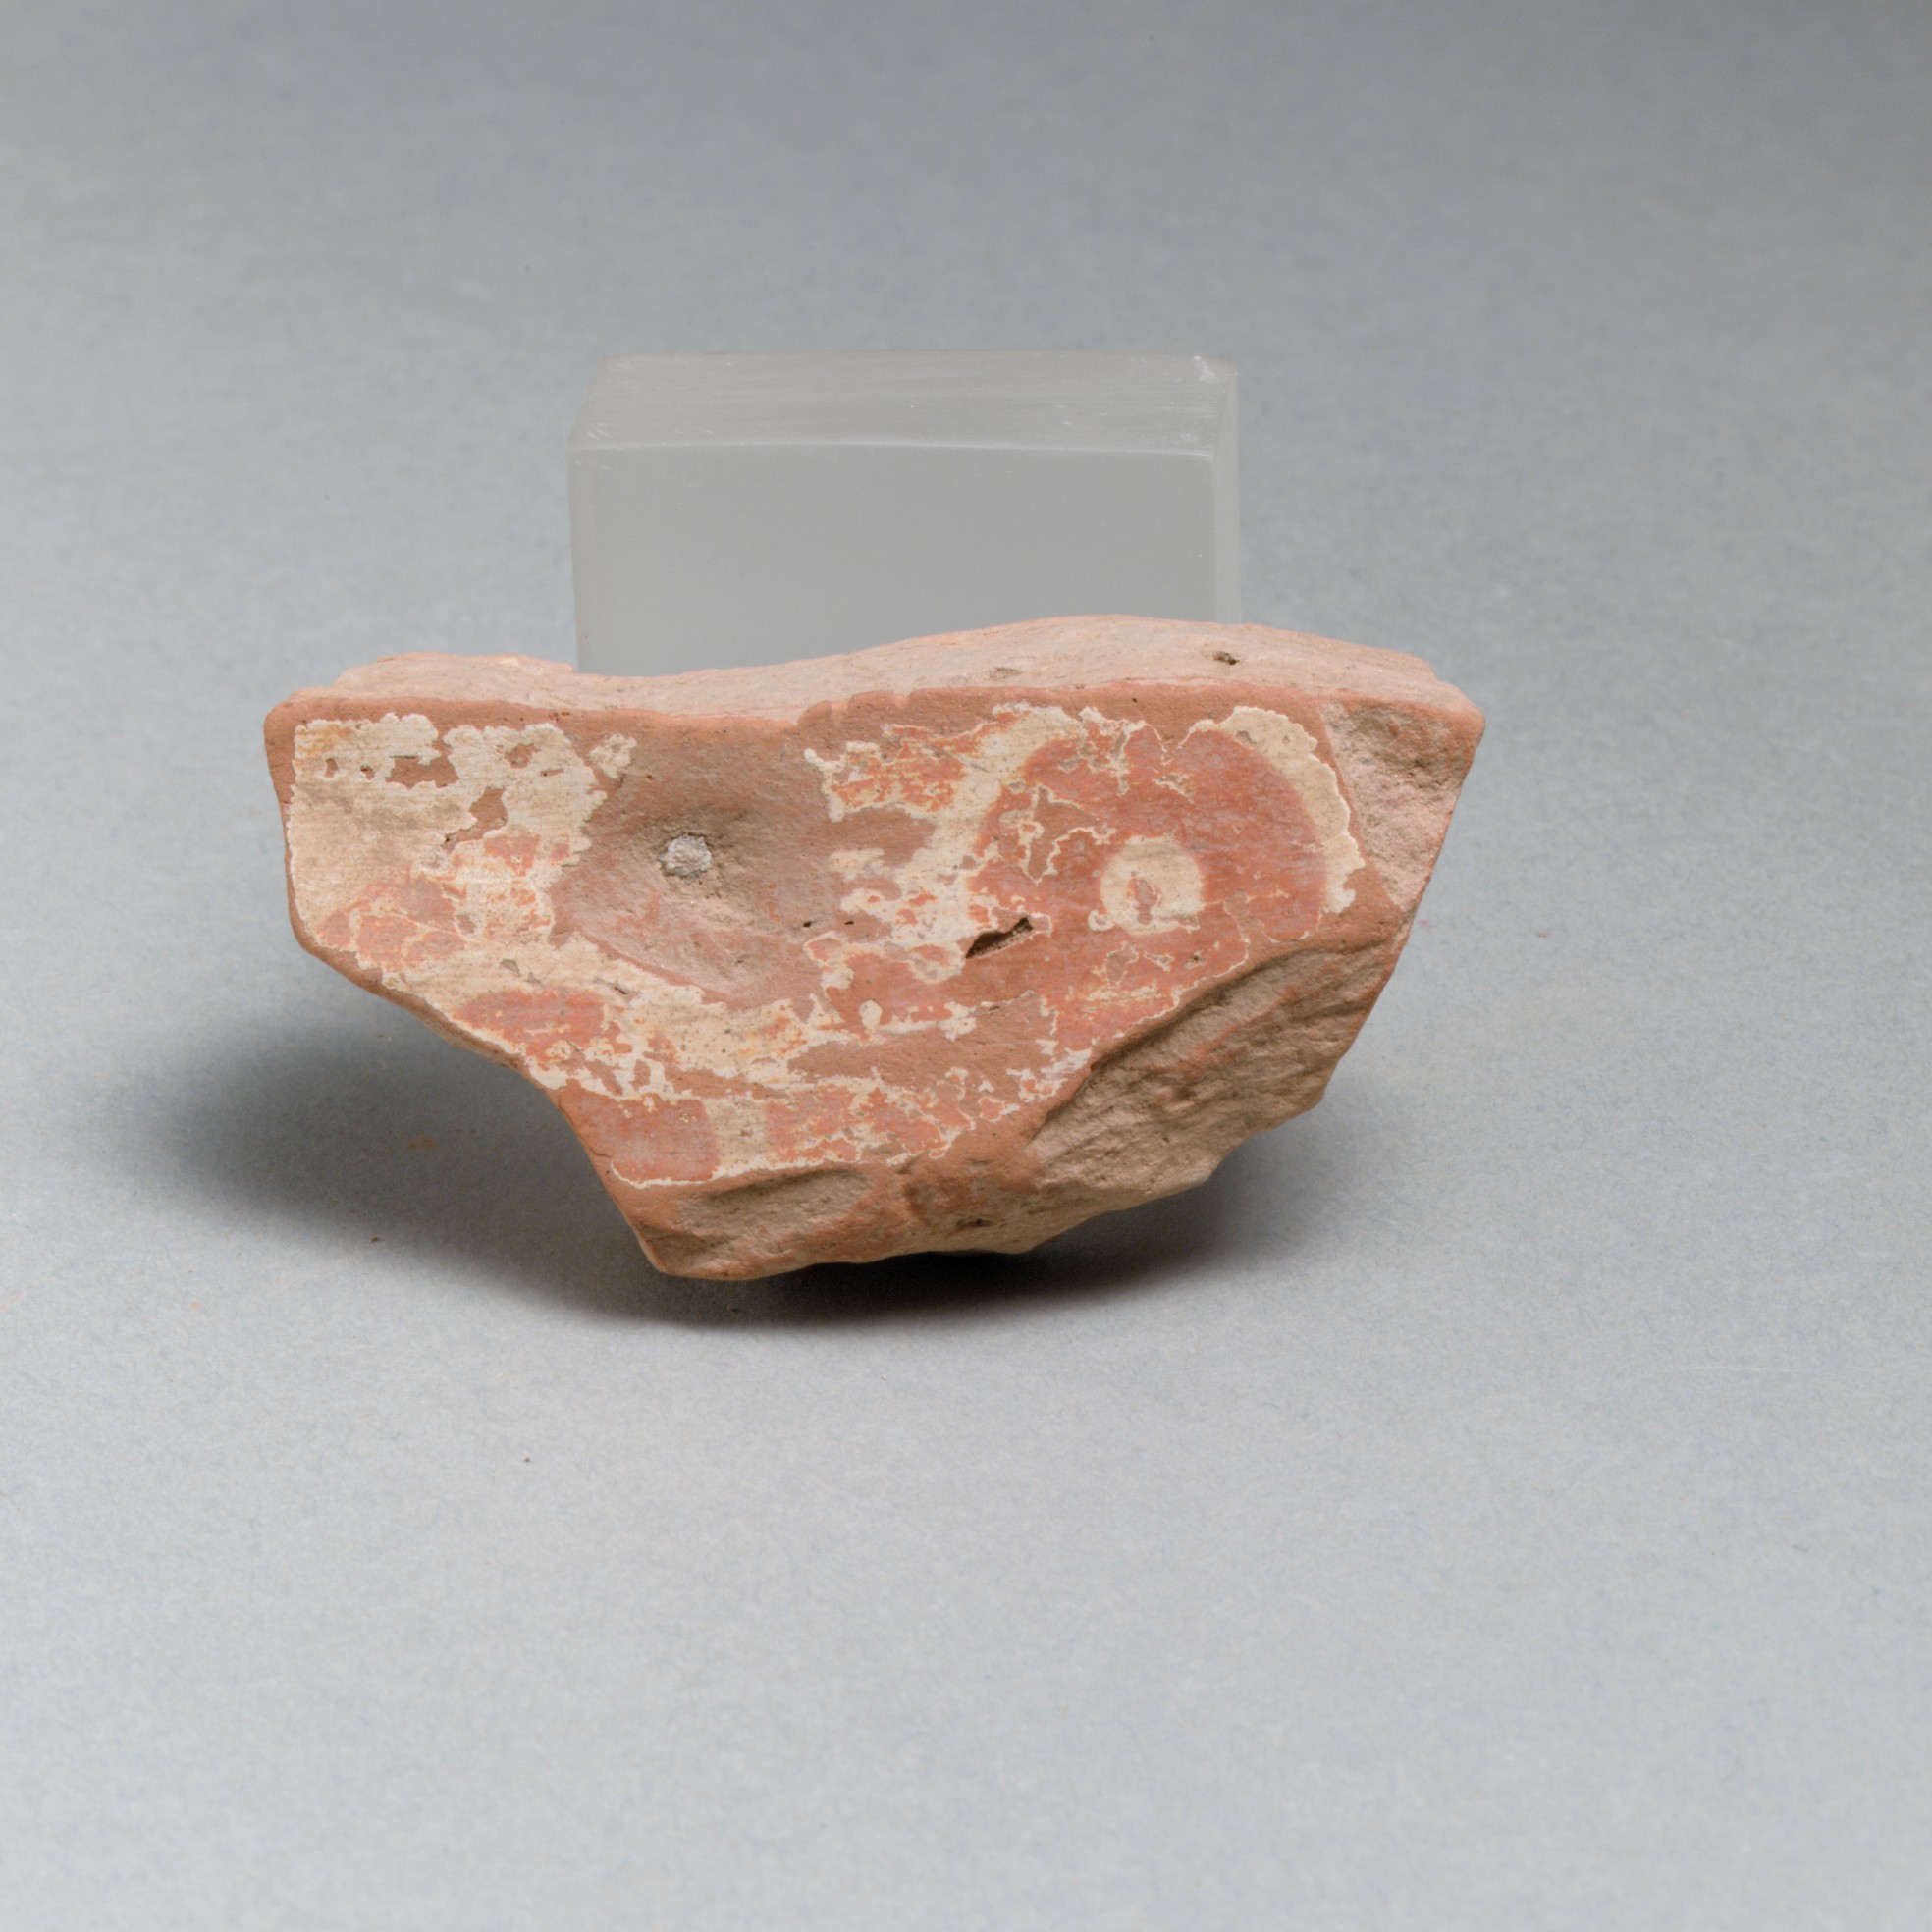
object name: vase fragment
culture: greek or lydian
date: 900-30 BCE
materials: terracotta